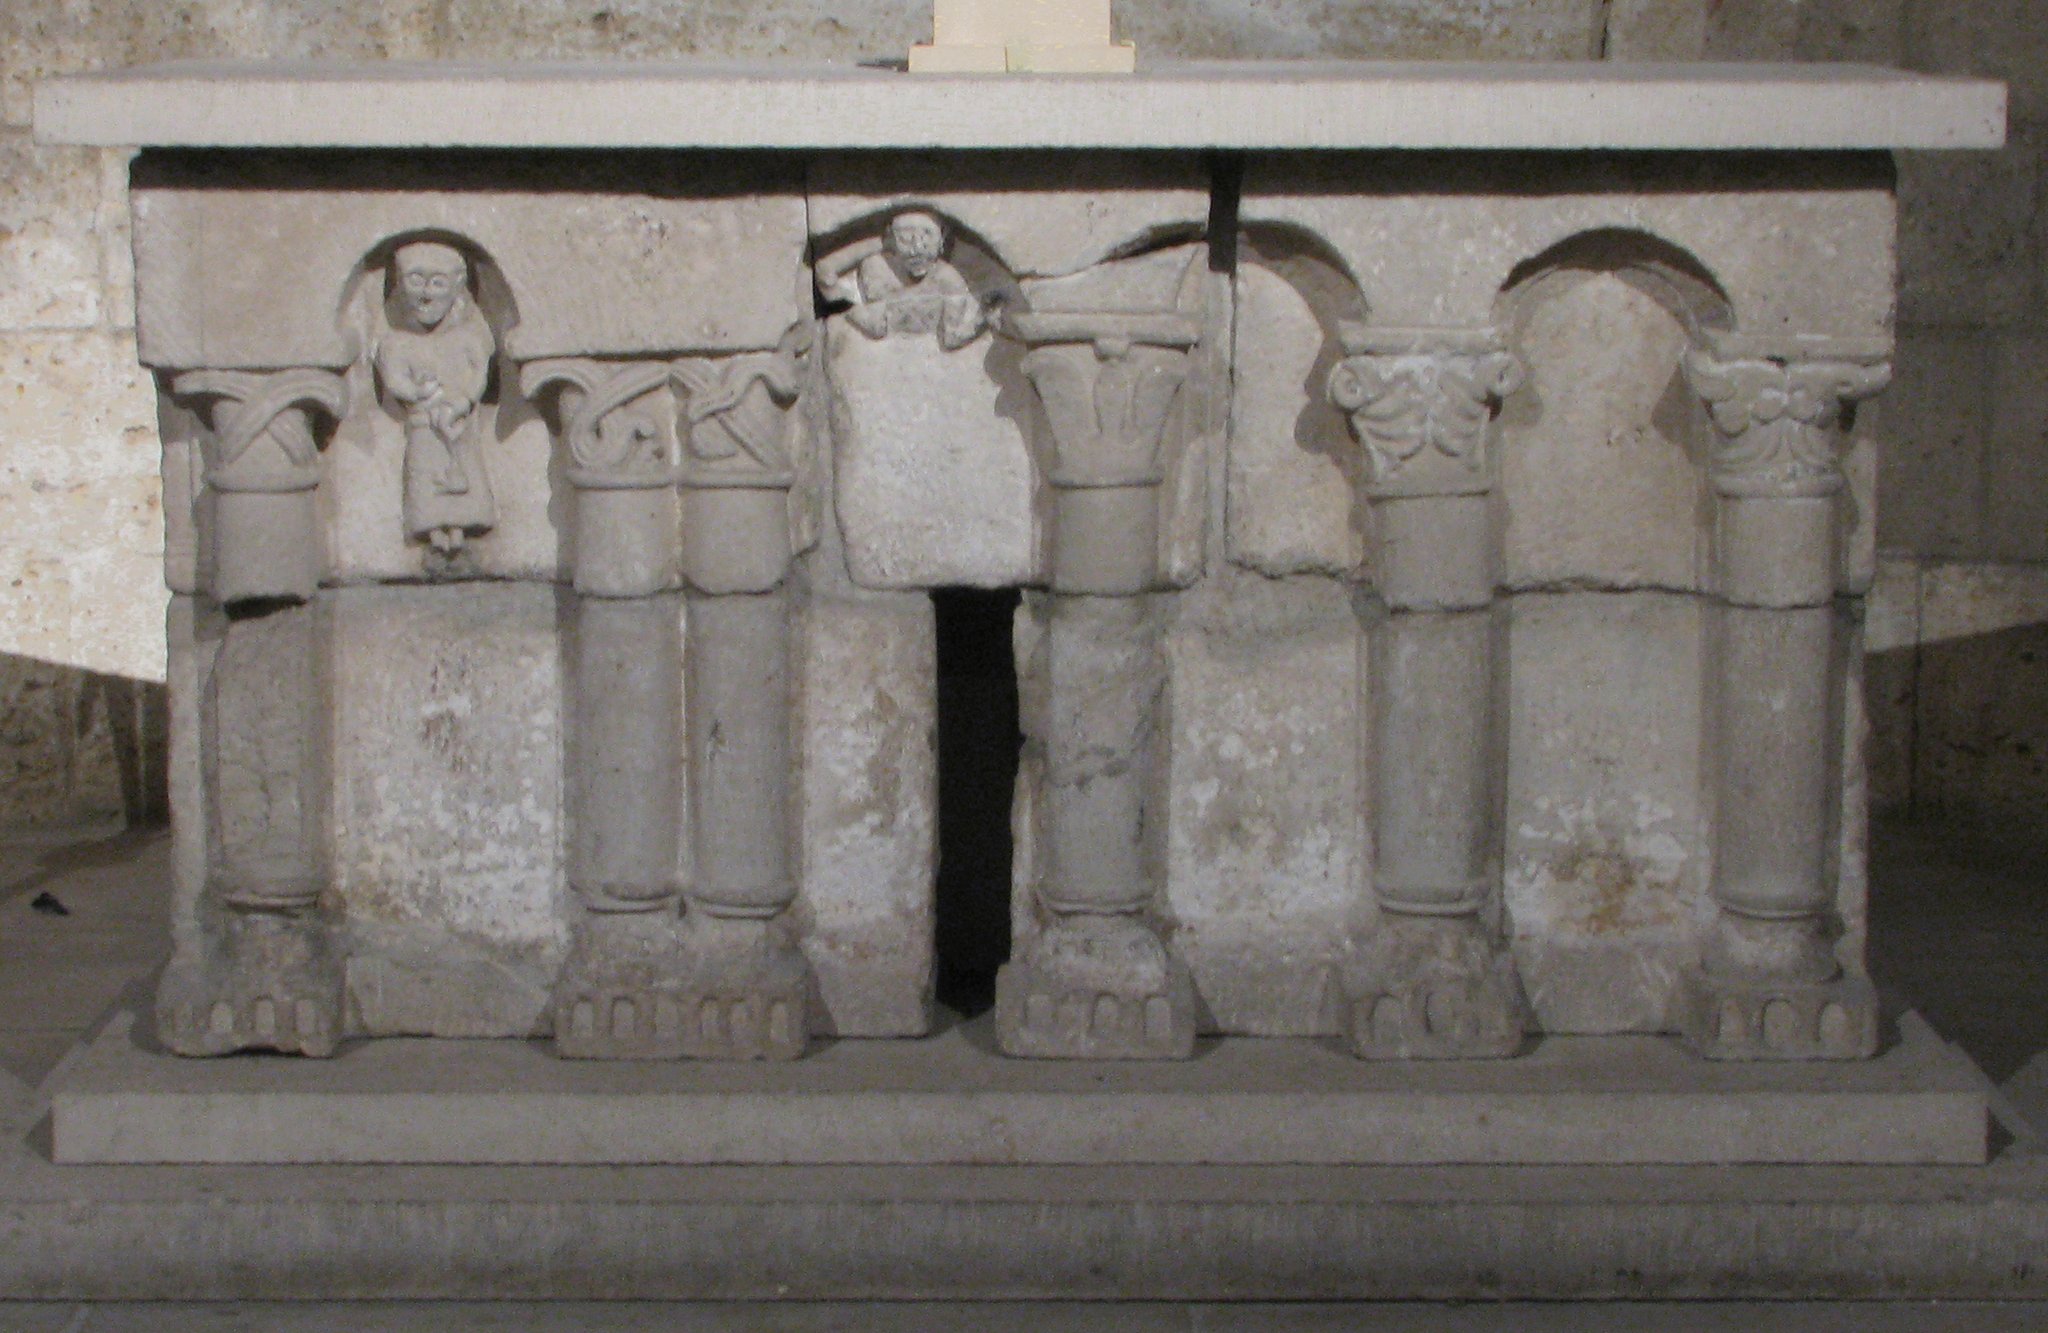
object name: altar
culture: spanish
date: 1167-1200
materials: stone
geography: spain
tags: altars